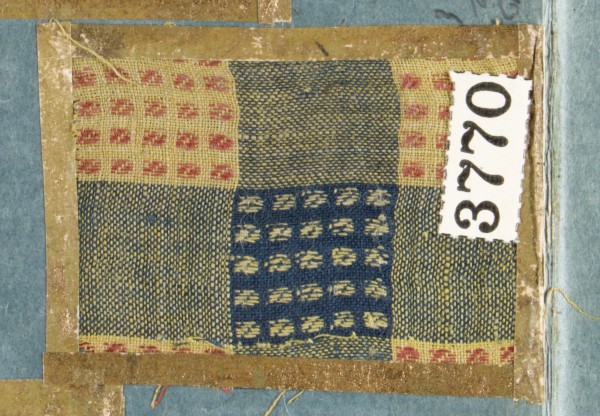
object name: sample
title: Textile Sample from Sample Book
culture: japanese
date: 1801-1900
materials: silk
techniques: tapestry